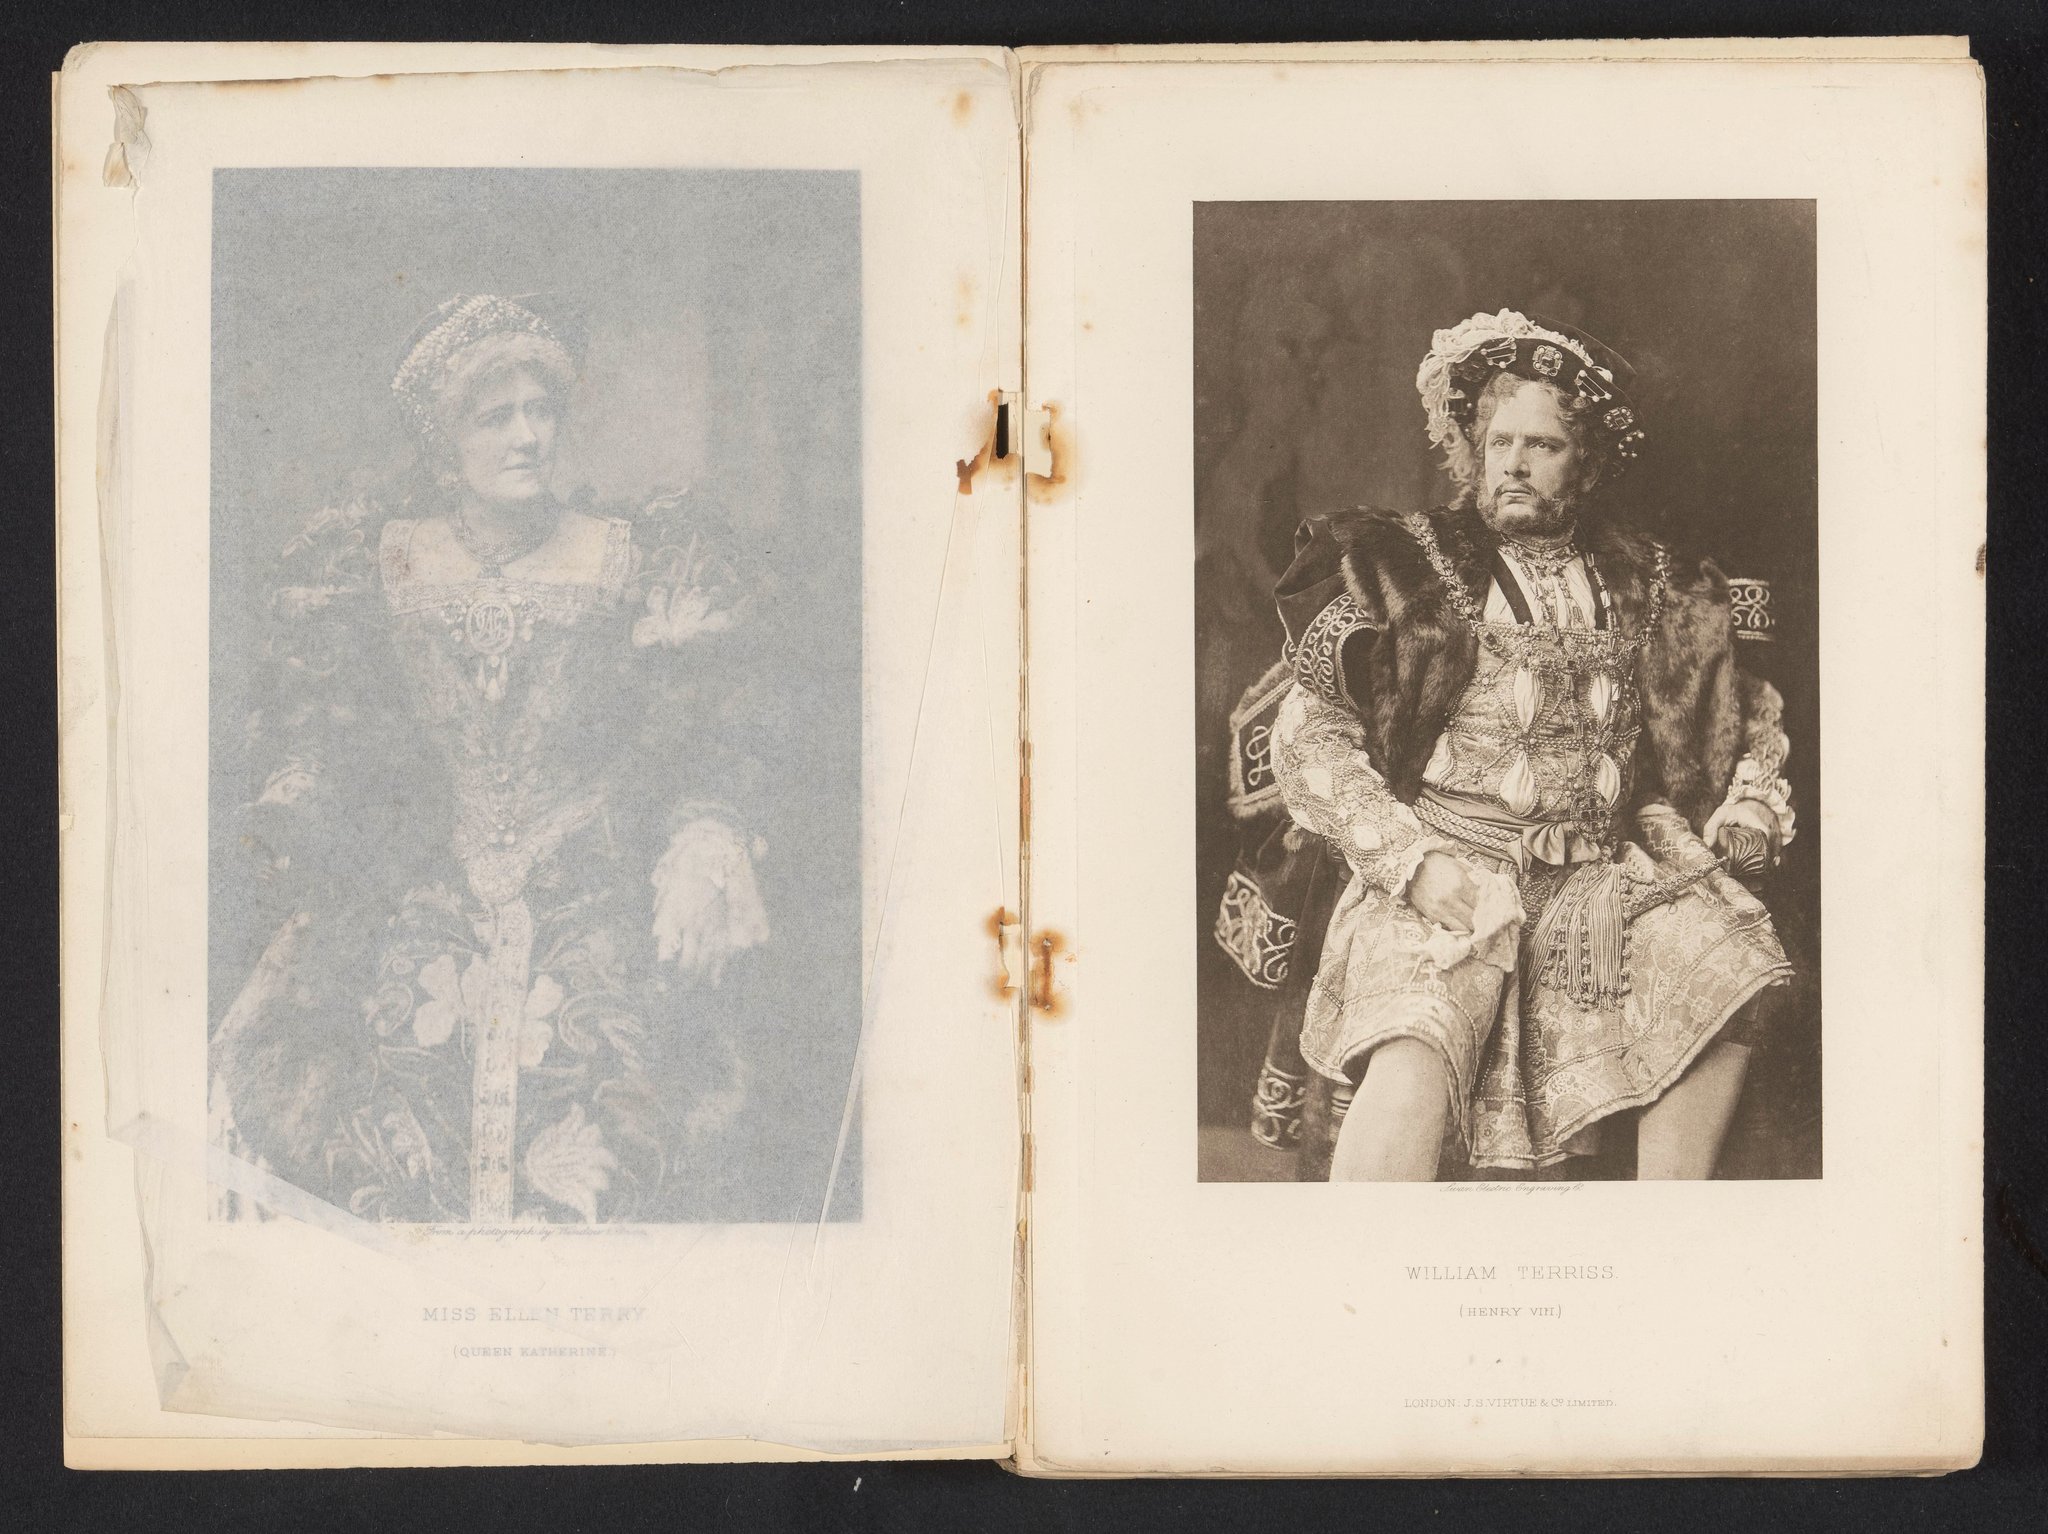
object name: photomechanical print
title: William Terriss (Henry VIII)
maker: Anonymous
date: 1880-1890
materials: paper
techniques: photoaquatint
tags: portrait of actor, actress